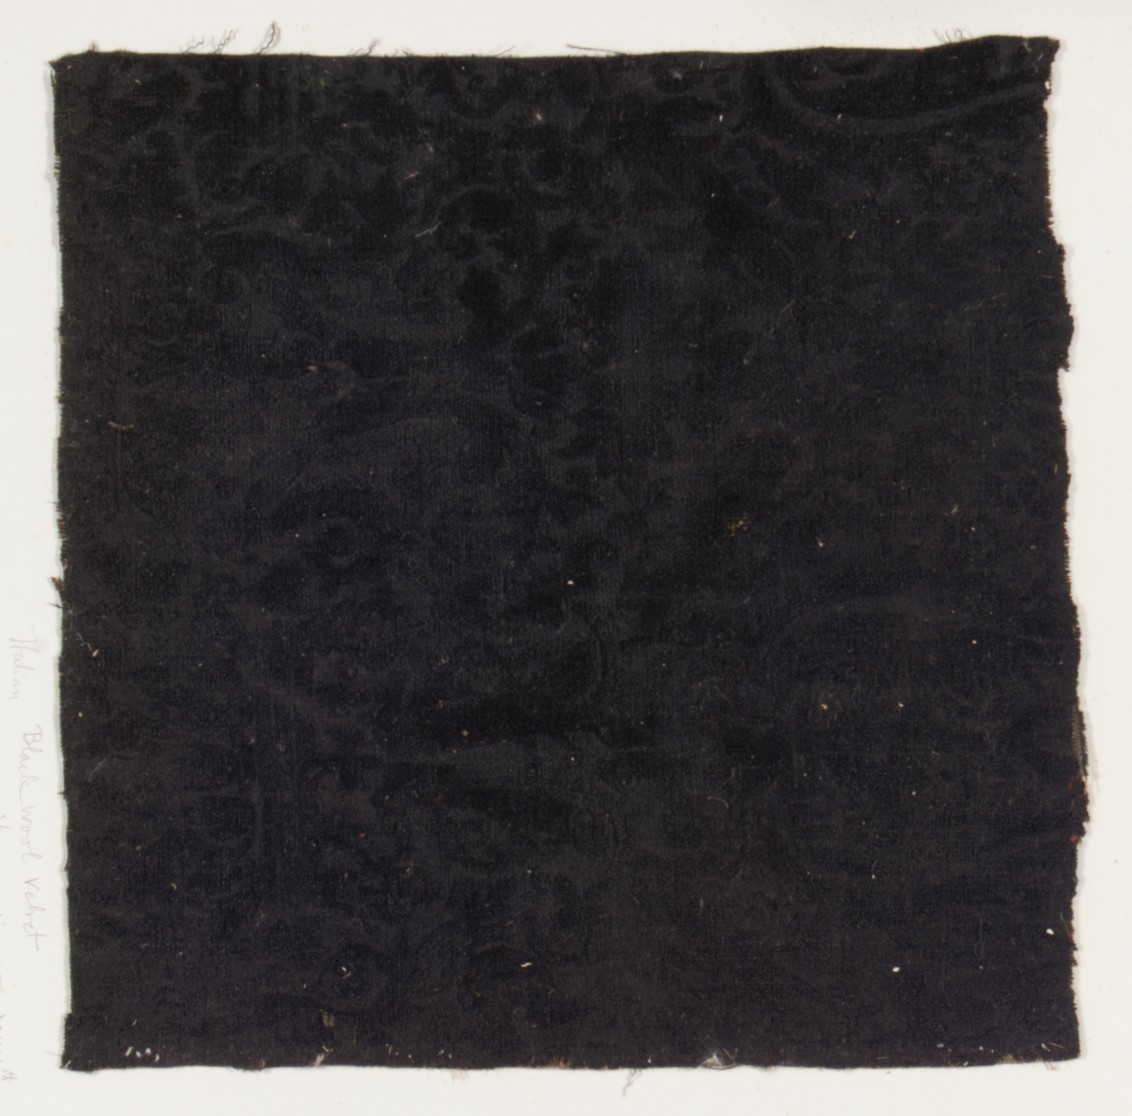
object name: fragment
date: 1601-1700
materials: wool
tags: flowers